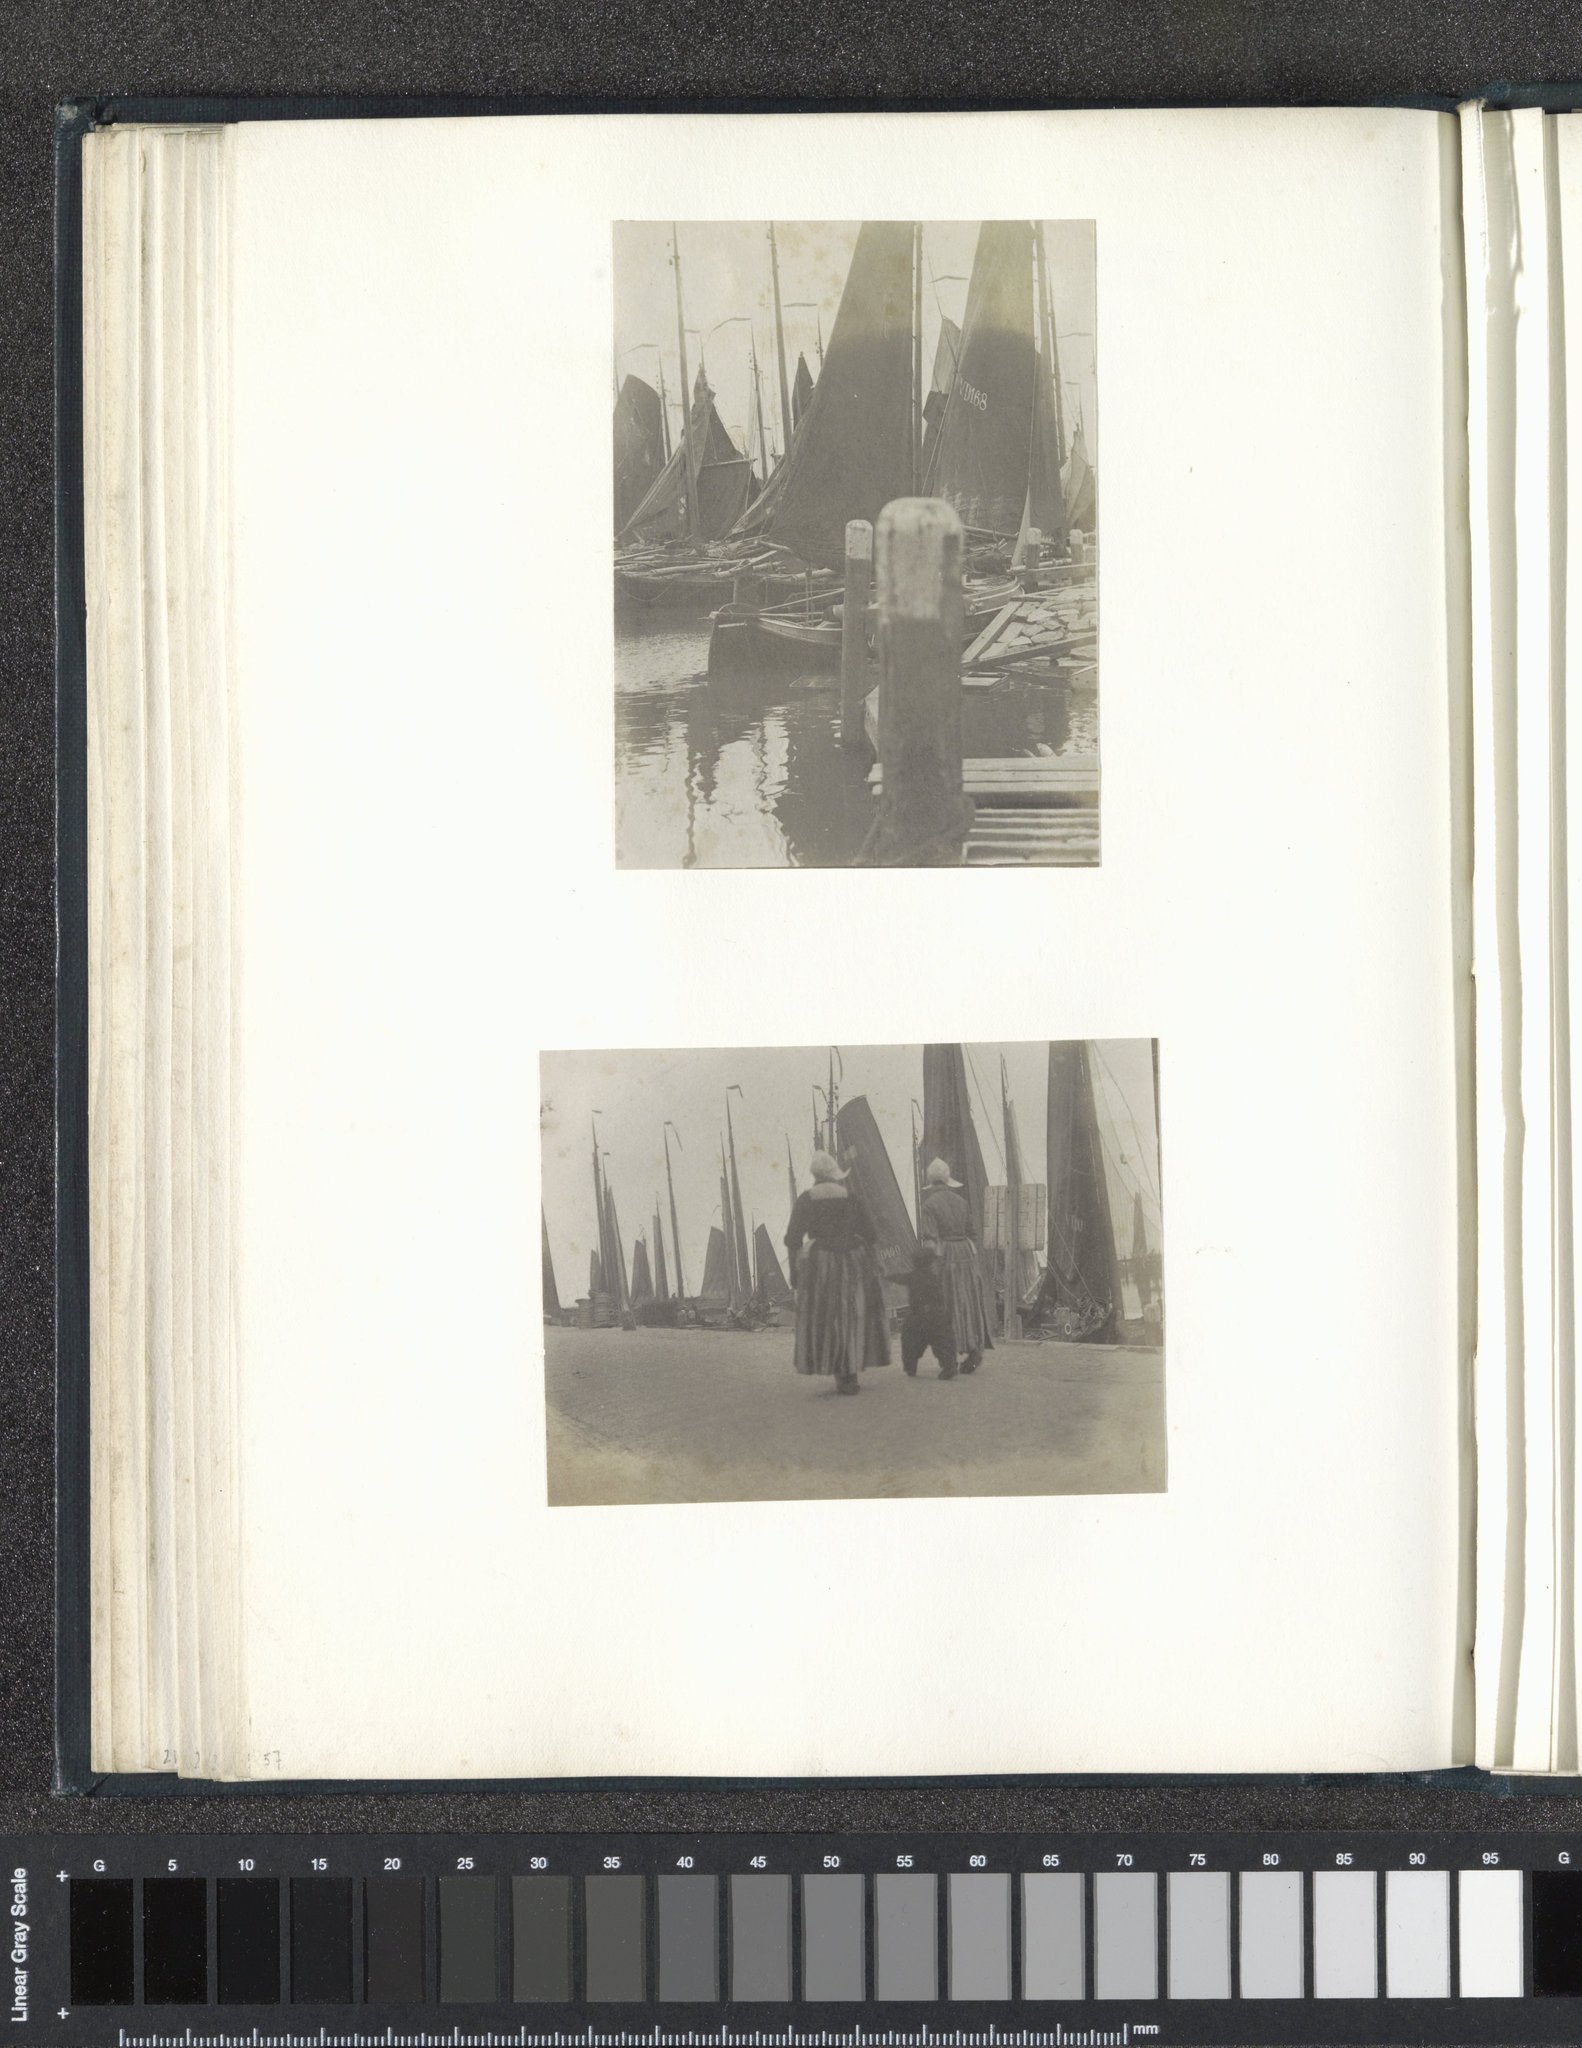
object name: photograph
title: Zeilschepen in de haven van Volendam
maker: george hidderley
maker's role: fotograaf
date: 1900-1910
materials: paper, photographic support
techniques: gelatin silver print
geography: volendam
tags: sailing-ship, sailing-boat, harbour (+ view ~ vehicle, ship, etc.)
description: Onderdeel van fotoalbum met opnames van Volendam, Dordrecht, Gorinchem en Woudrichem.